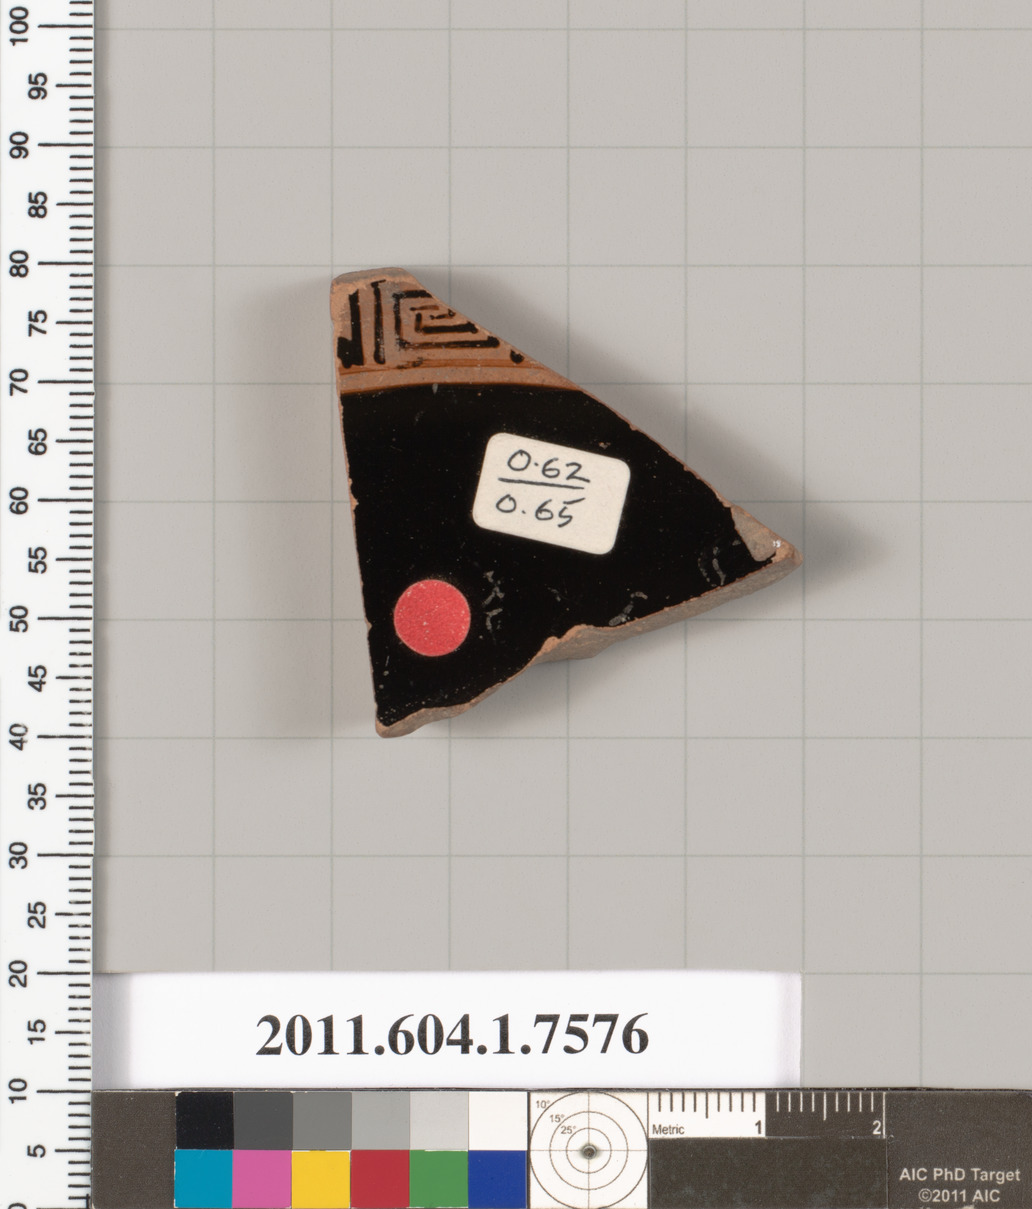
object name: kylix fragment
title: Terracotta fragment of a kylix (drinking cup)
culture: greek, attic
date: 460-450 BCE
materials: terracotta